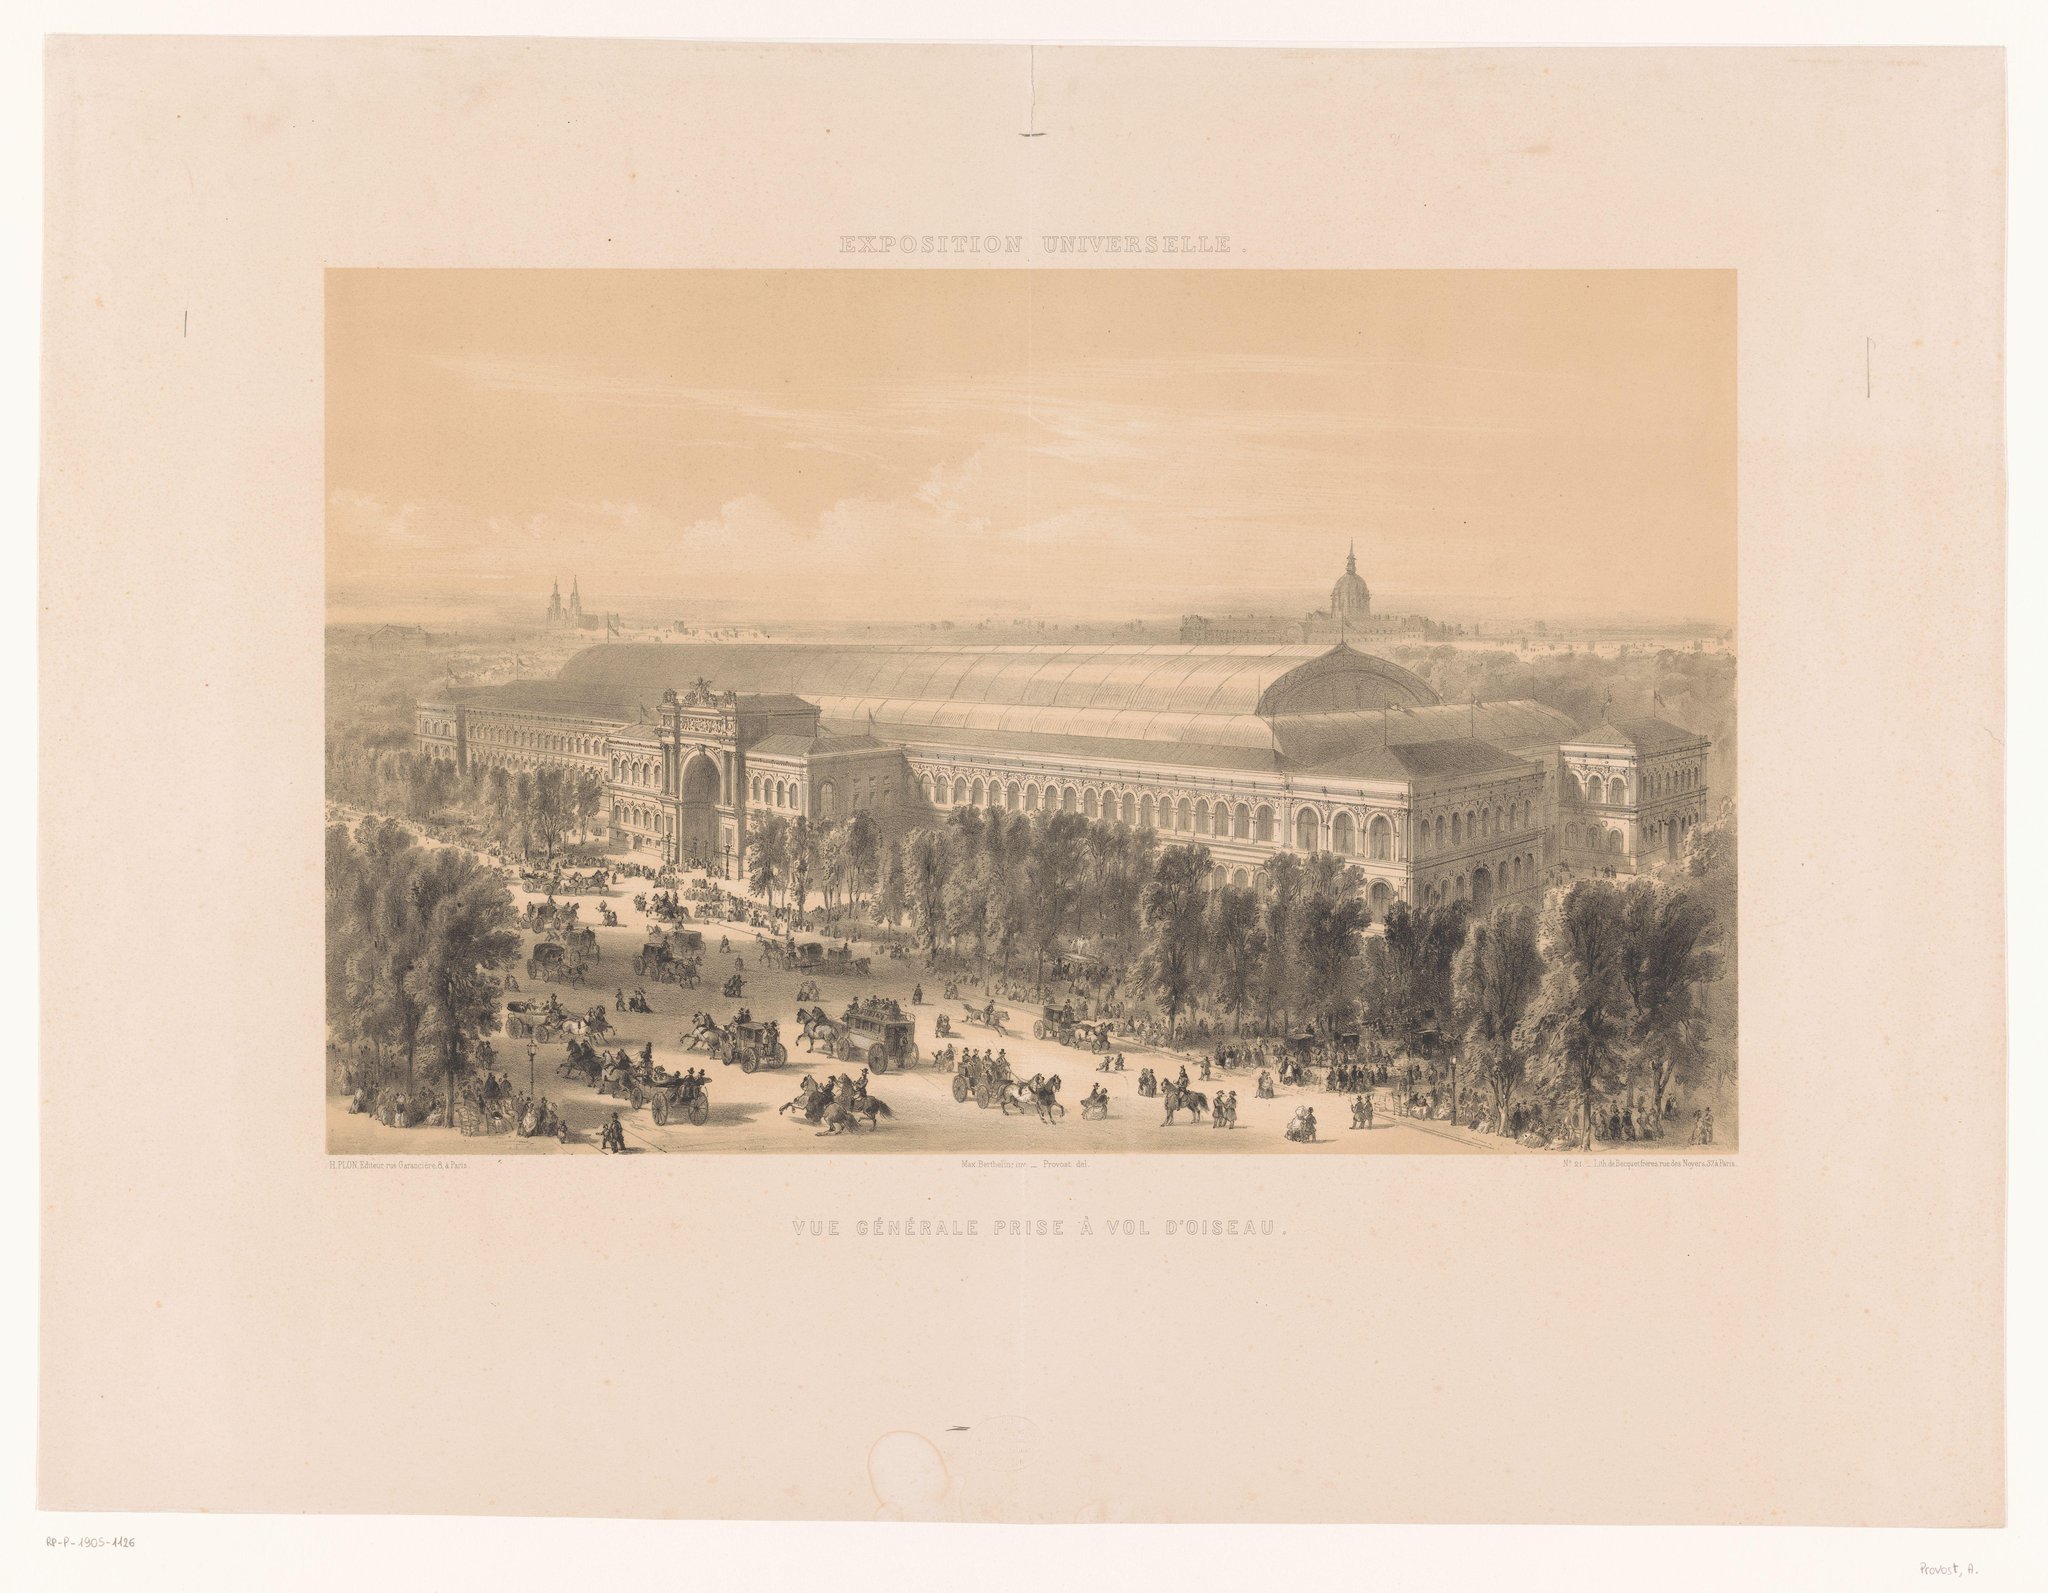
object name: print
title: Gezicht op Palais de l'Industrie te Parijs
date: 1855-1862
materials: paper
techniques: tone lithography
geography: france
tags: world fair, world exhibition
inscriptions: check stamp: ‘H. Plon/ seul éditeur autorisé/ pour les vues/ du Palais de l'Industrie/ 3.R. Garancière’, collector's mark: Lugt 2228